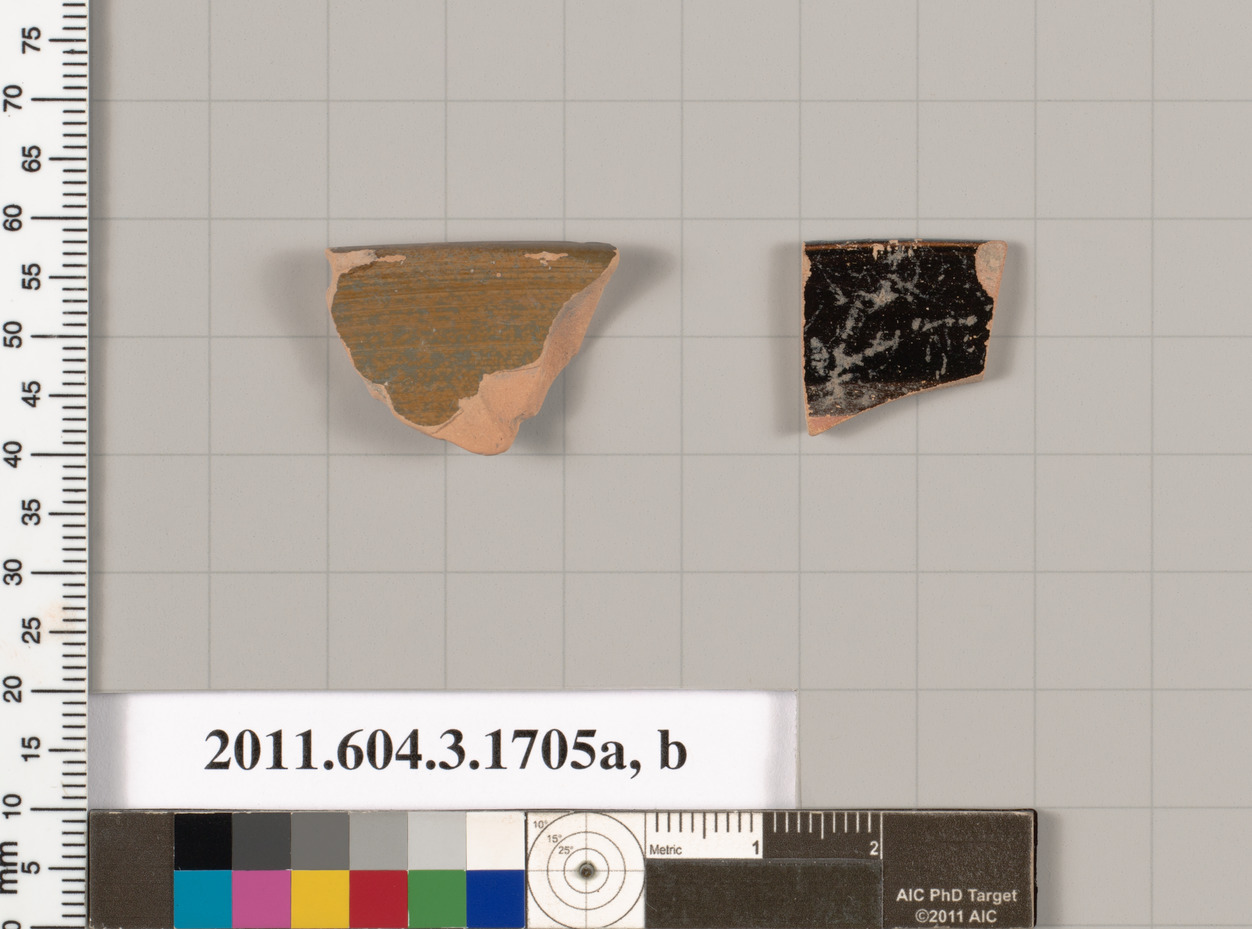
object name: kylix fragment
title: Terracotta rim fragments of kylikes: Band cups (drinking cups)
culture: greek, attic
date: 550-526 BCE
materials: terracotta